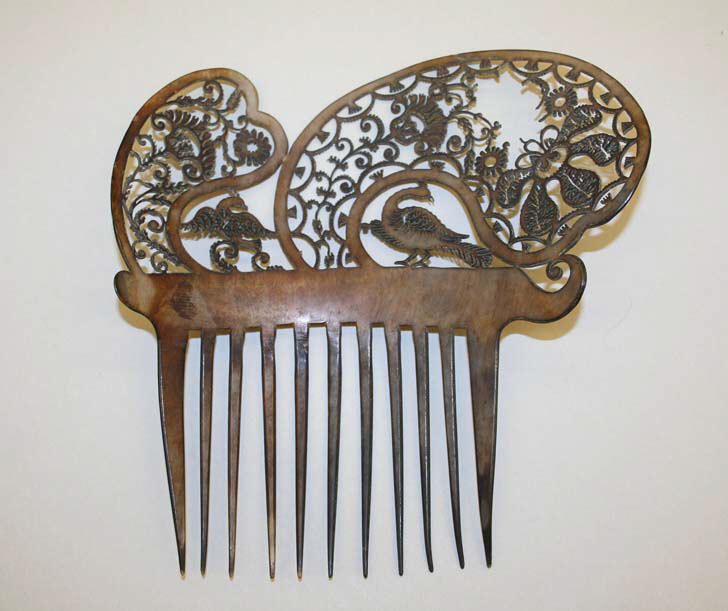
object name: comb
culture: german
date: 1801-1900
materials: shell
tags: birds